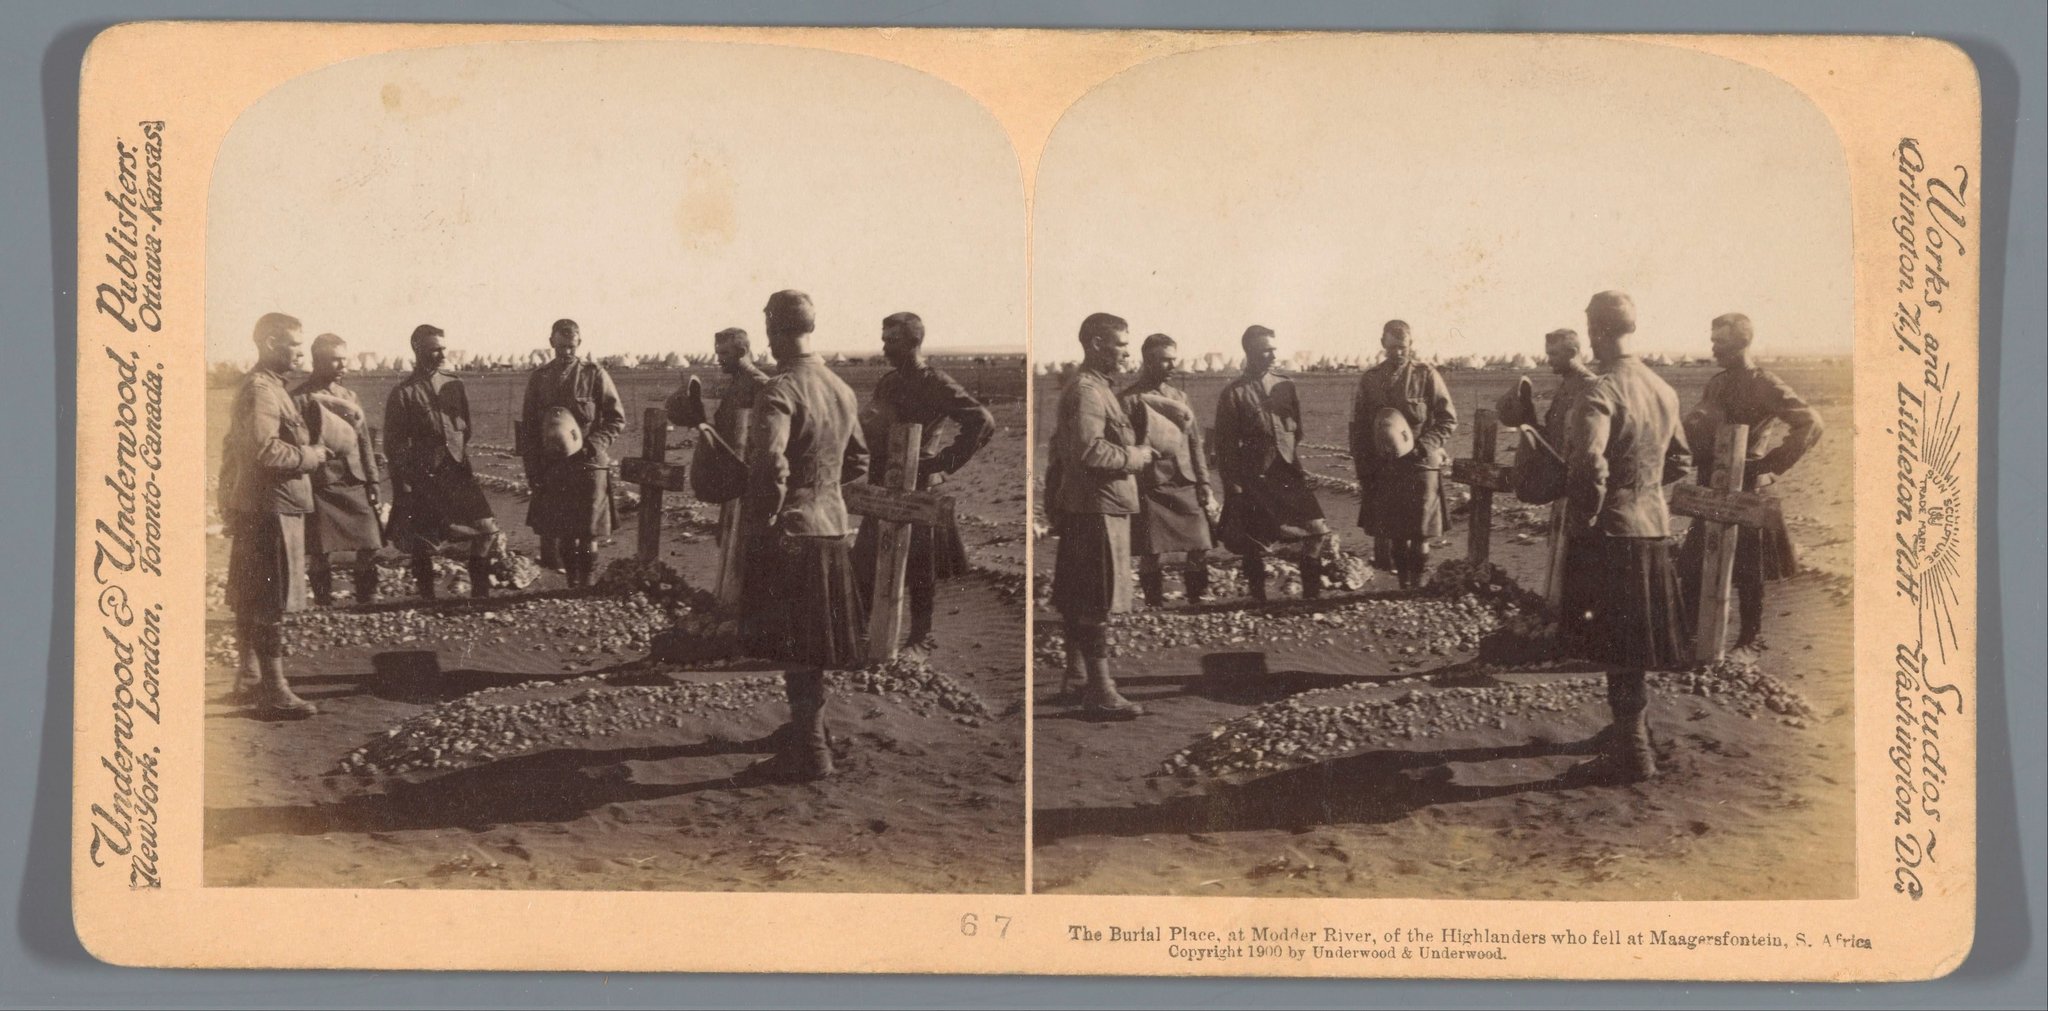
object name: stereograph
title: The Burial Place, at Modder River, of the Highlanders who fell at Maagersfontein, S. Africa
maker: Anonymous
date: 1900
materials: cardboard, paper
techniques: albumen print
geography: new york city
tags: burial, grave, tomb, the soldier; the soldier's life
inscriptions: number: ‘67’, inscription: ‘Works and Studios ~/ Arlington, N.J. Littleton, N.H. Washington, D.C.’, inscription, copyright notice: ‘Copyright 1900 by Underwood & Underwood.’